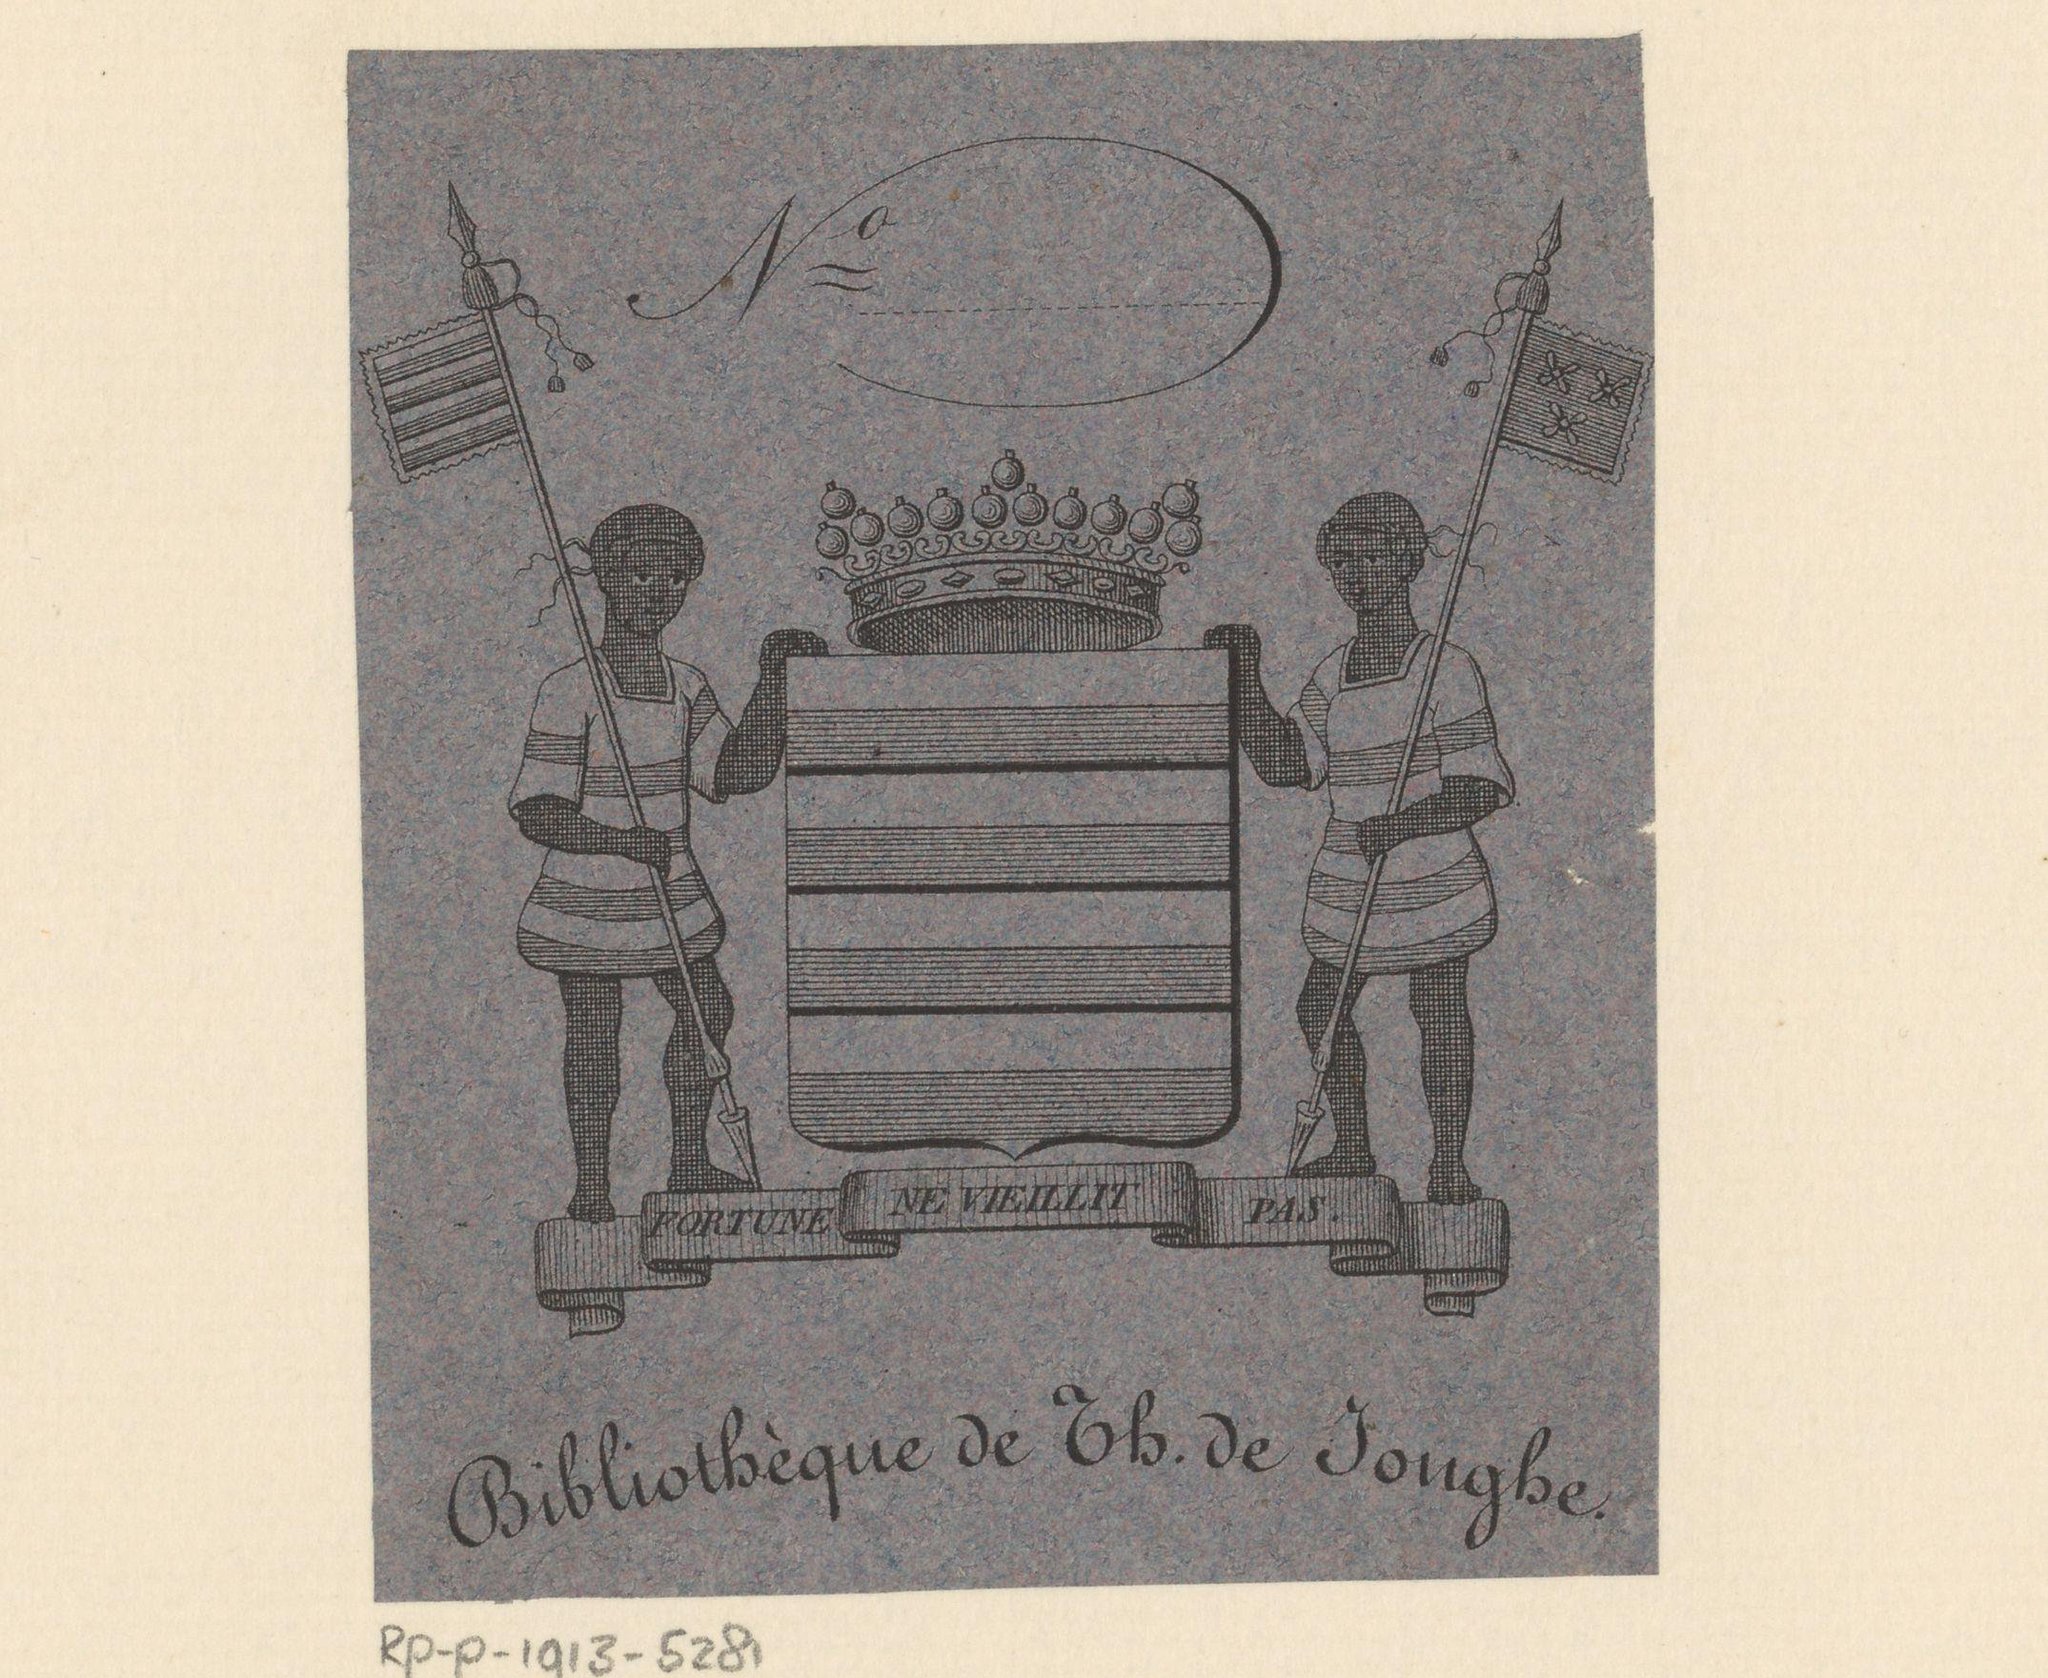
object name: bookplate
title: Ex libris van Bibliothèque de Th. de Jonghe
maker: Anonymous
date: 1800-1899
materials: paper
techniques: etching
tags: armorial bearing, heraldry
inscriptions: collector's mark: Lugt 2233, collector's mark: Lugt 2760